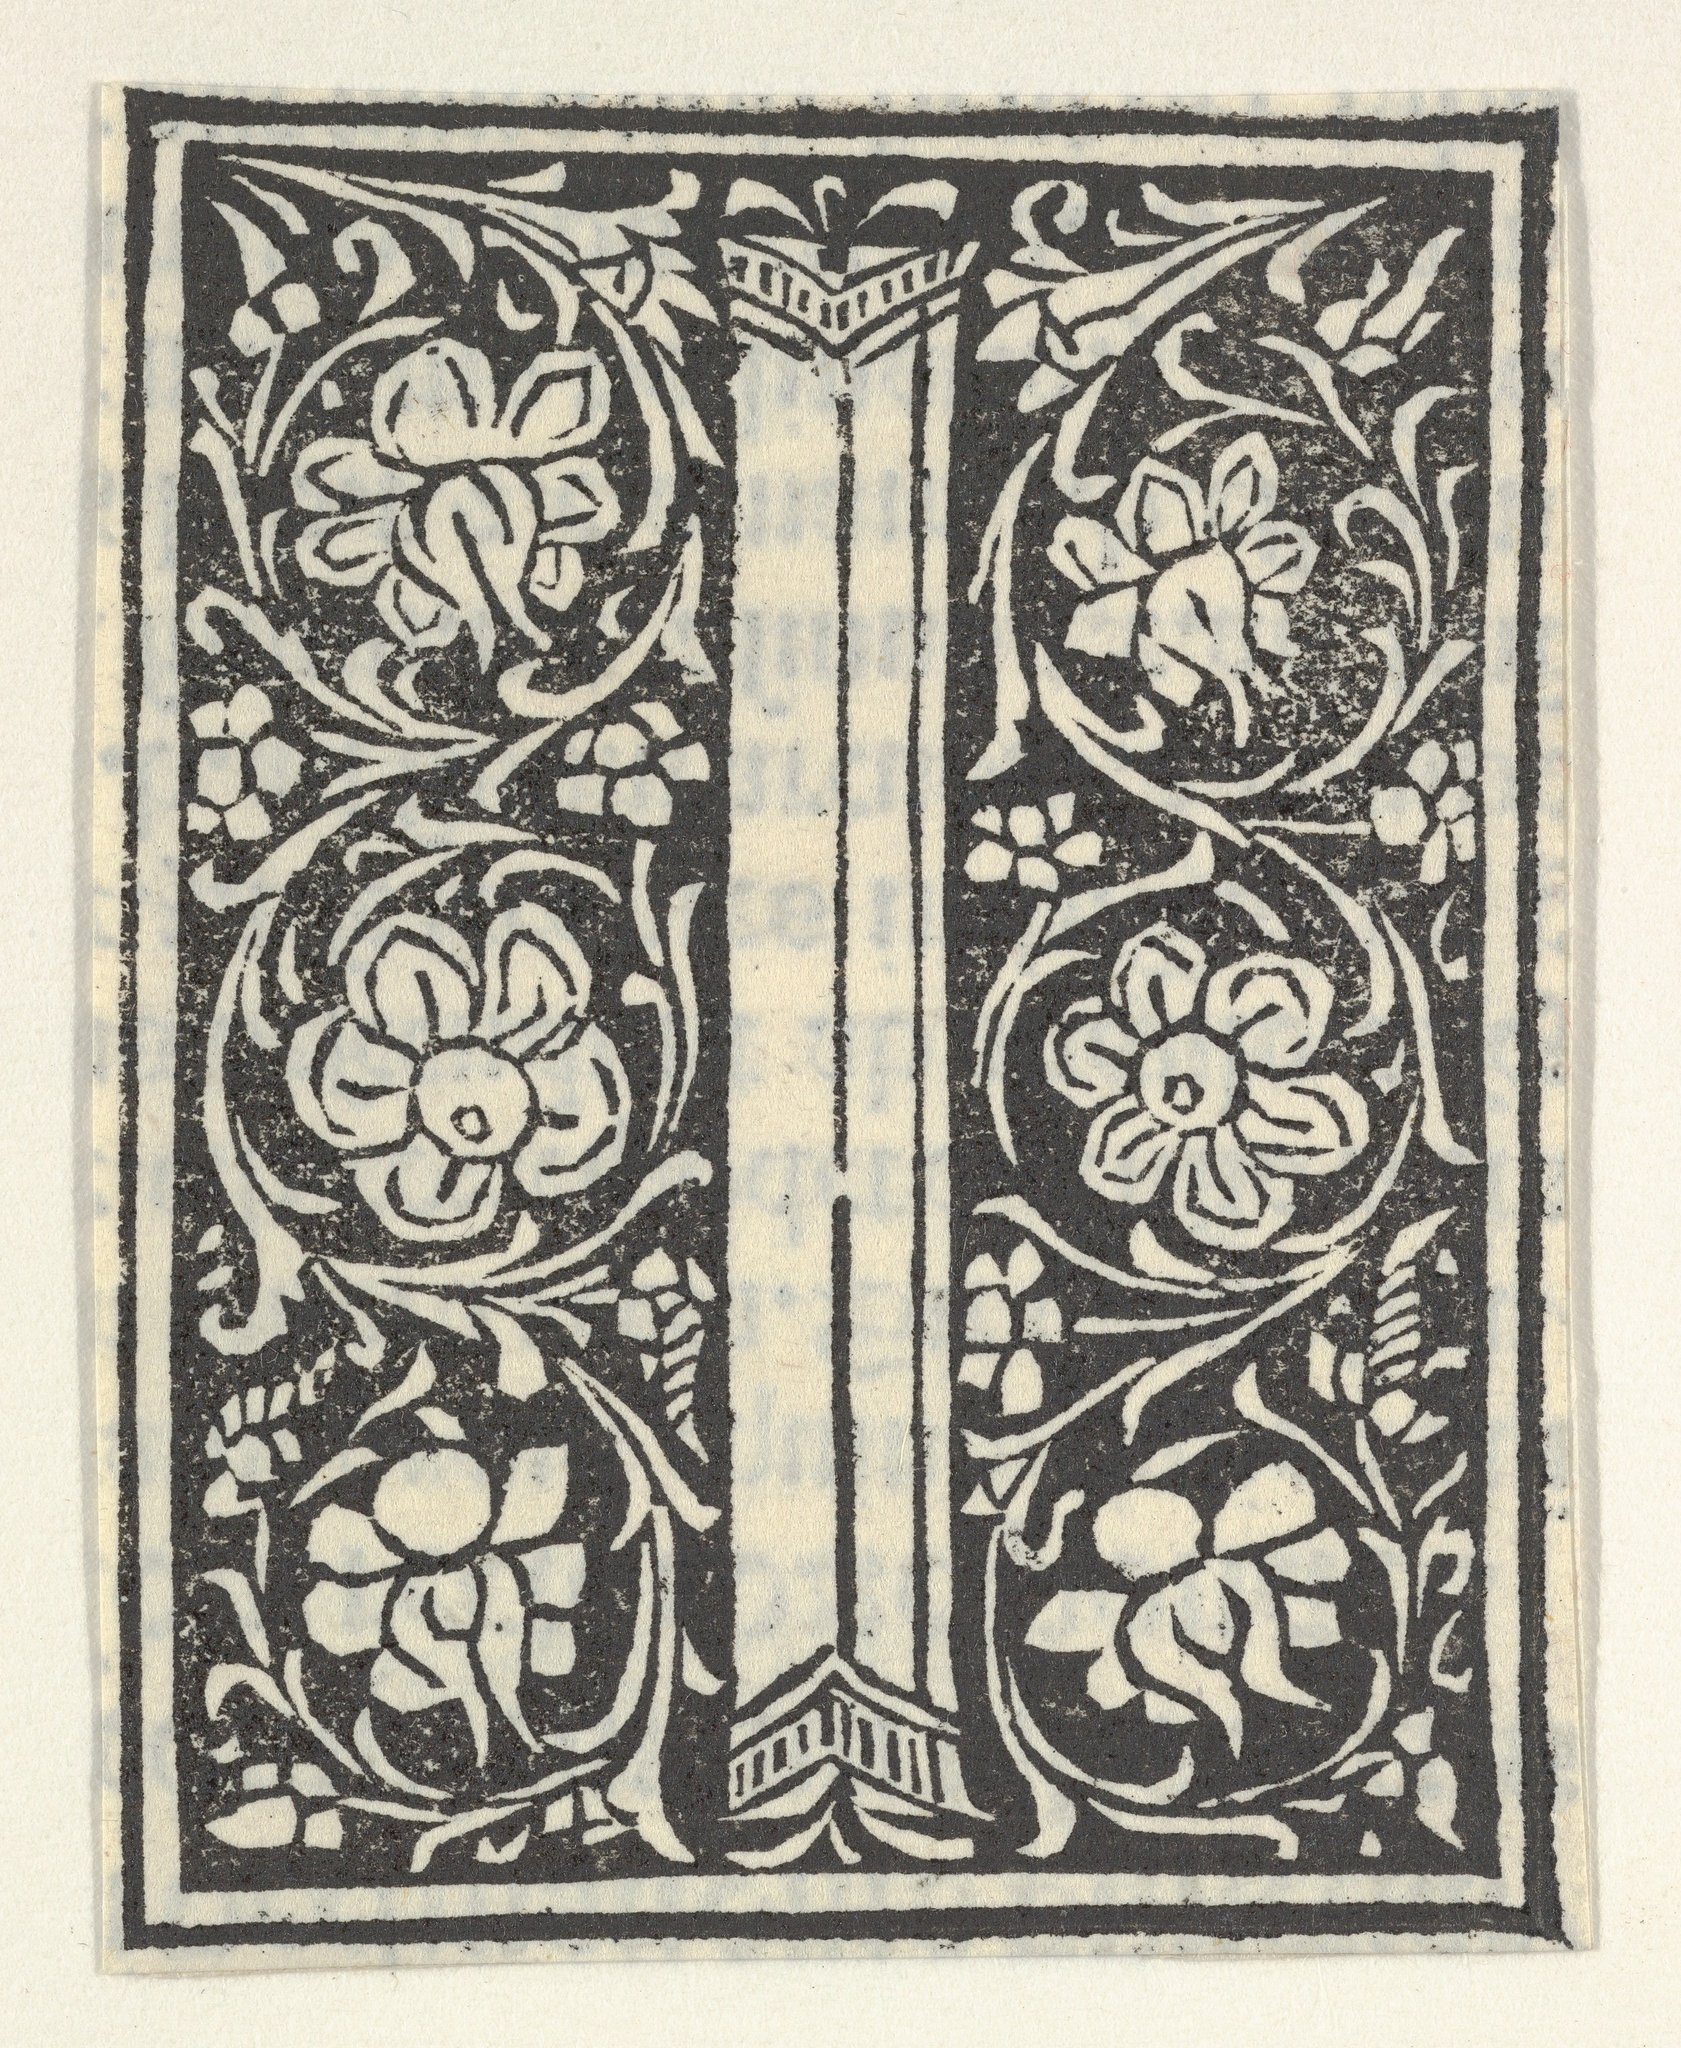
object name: print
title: Initial letter I with flowers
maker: anonymous, italian, 15th century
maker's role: artist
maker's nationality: italian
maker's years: 1400-1500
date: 1496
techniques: woodcut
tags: flowers